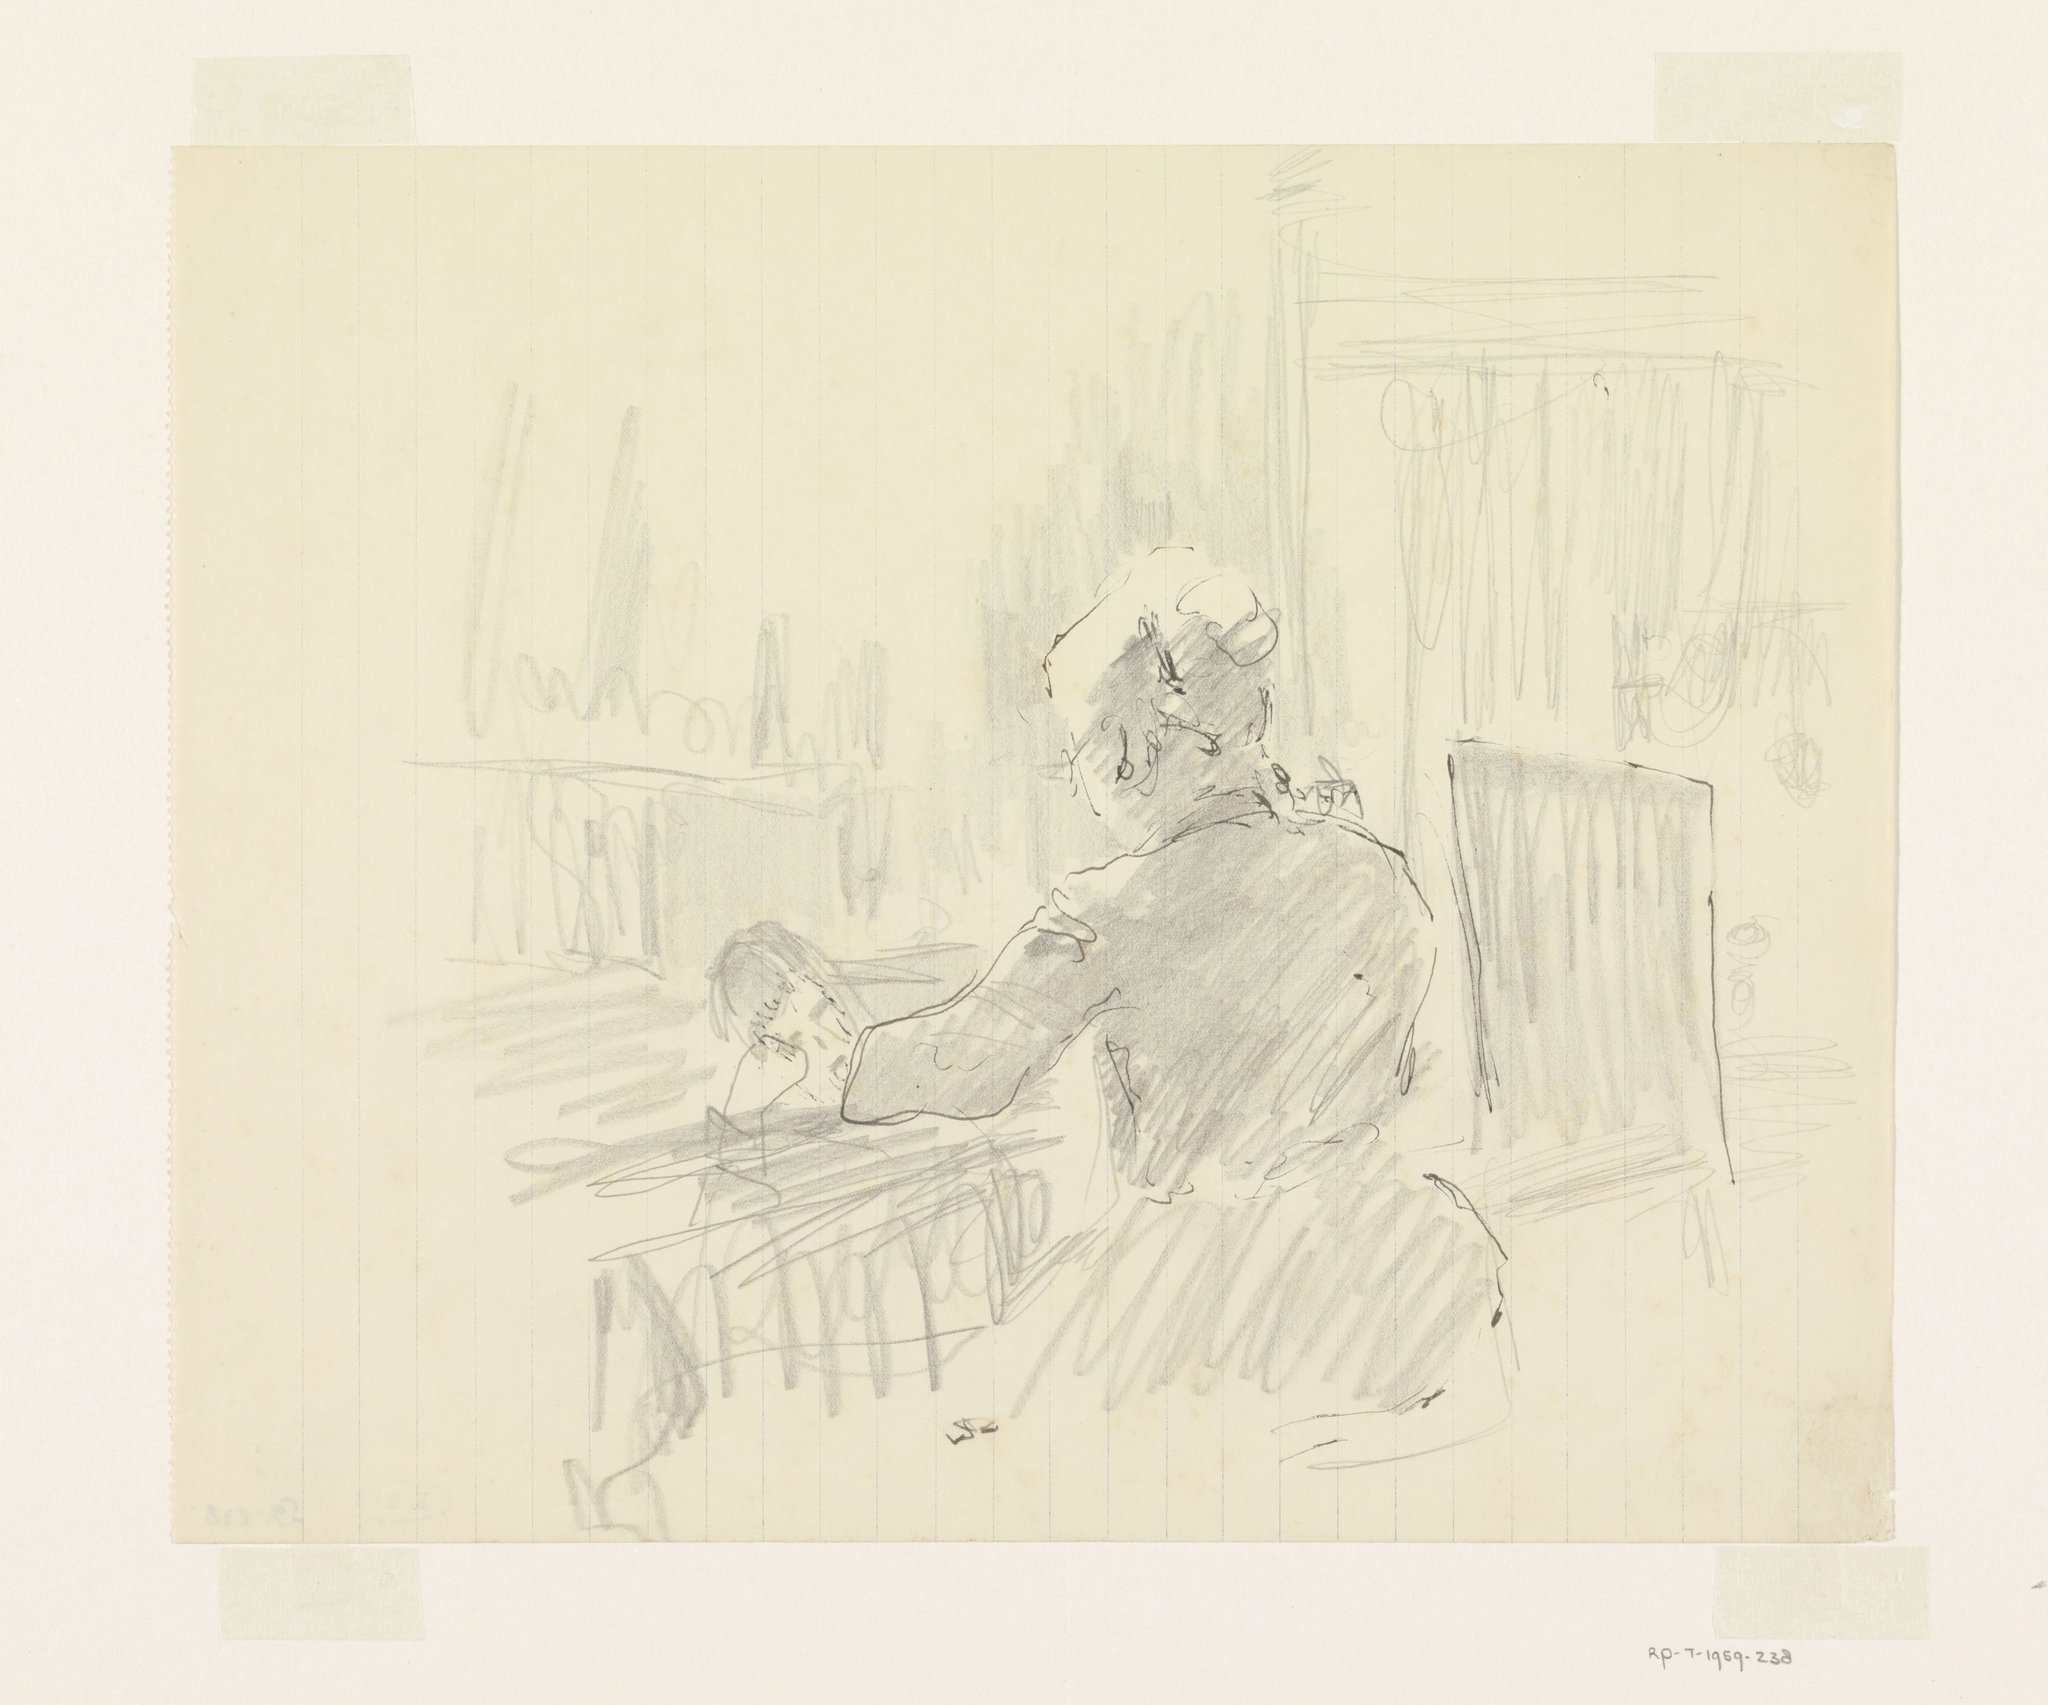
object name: drawing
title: Studie van de echtgenote van Carel Adolph Lion Cachet, handwerkend, op de rug gezien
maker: carel adolph lion cachet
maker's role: draughtsman, print maker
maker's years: 1864-1945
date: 1874-1945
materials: ink, paper, pencil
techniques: pen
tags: historical persons - bb - woman, (other forms of) needlework, e.g.: crocheting, knitting, embroidering